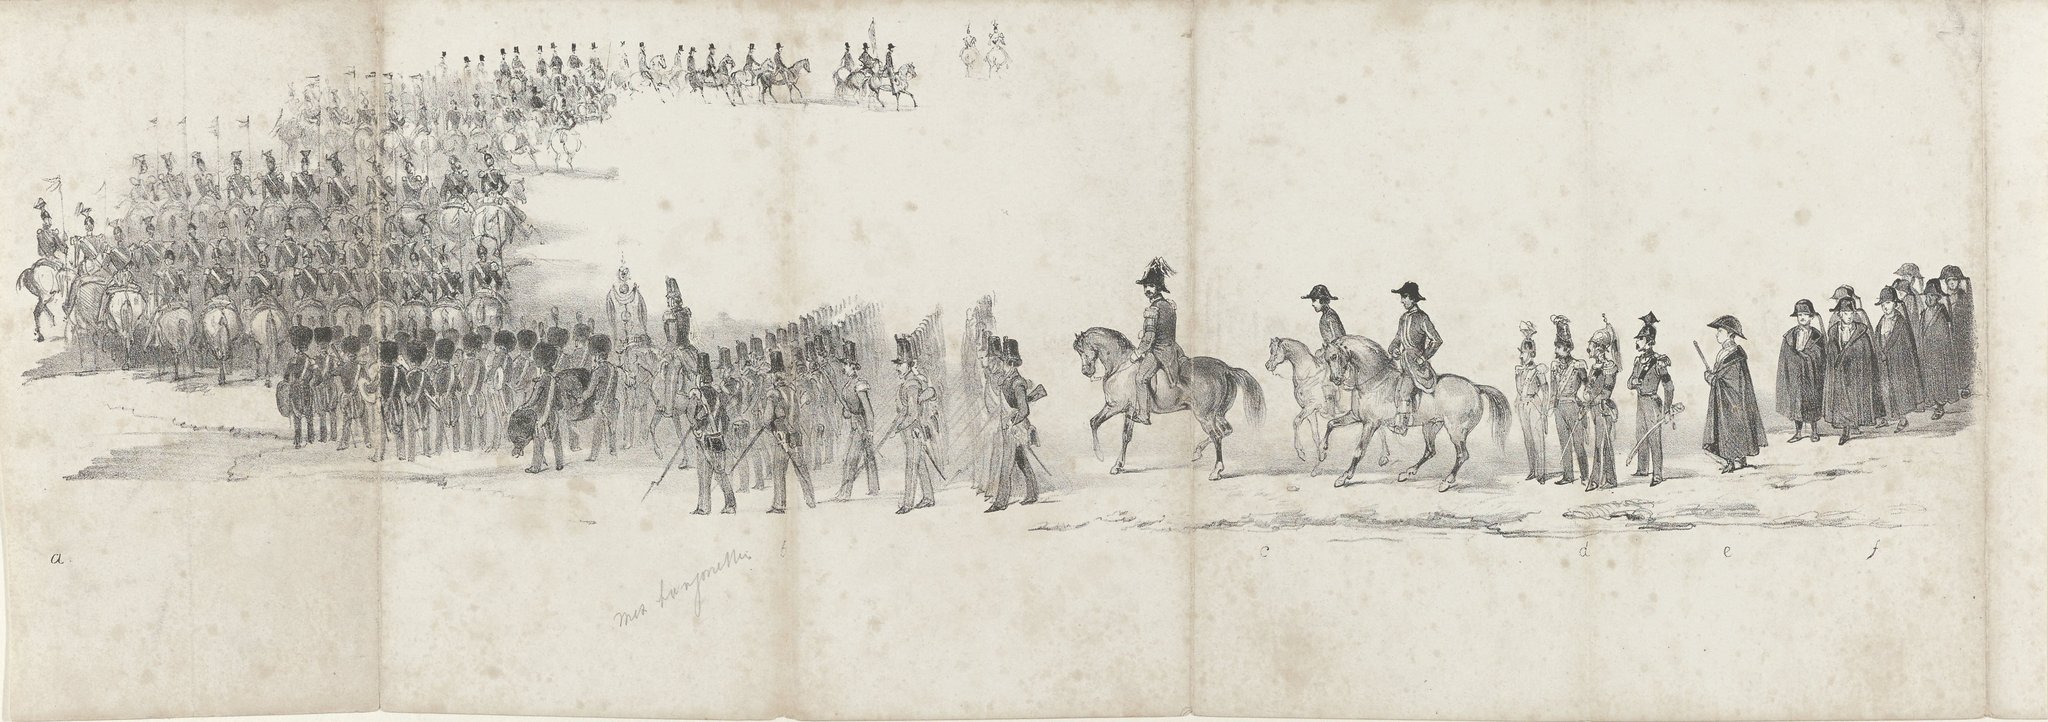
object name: print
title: Begrafenis van wijlen koning Willem II te Delft op 4 april 1849 (blad 1)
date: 1849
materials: paper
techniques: lithograph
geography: haarlem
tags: the hague, william ii of the netherlands, cortege, funeral procession, delft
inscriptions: collector's mark: Lugt 2228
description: De begrafenis van wijlen koning Willem II te Delft op 4 april 1849. Eerste blad in een reeks van vijf aaneengesloten bladen. Op dit blad het begin van de begrafenisstoet met de letters a-f.